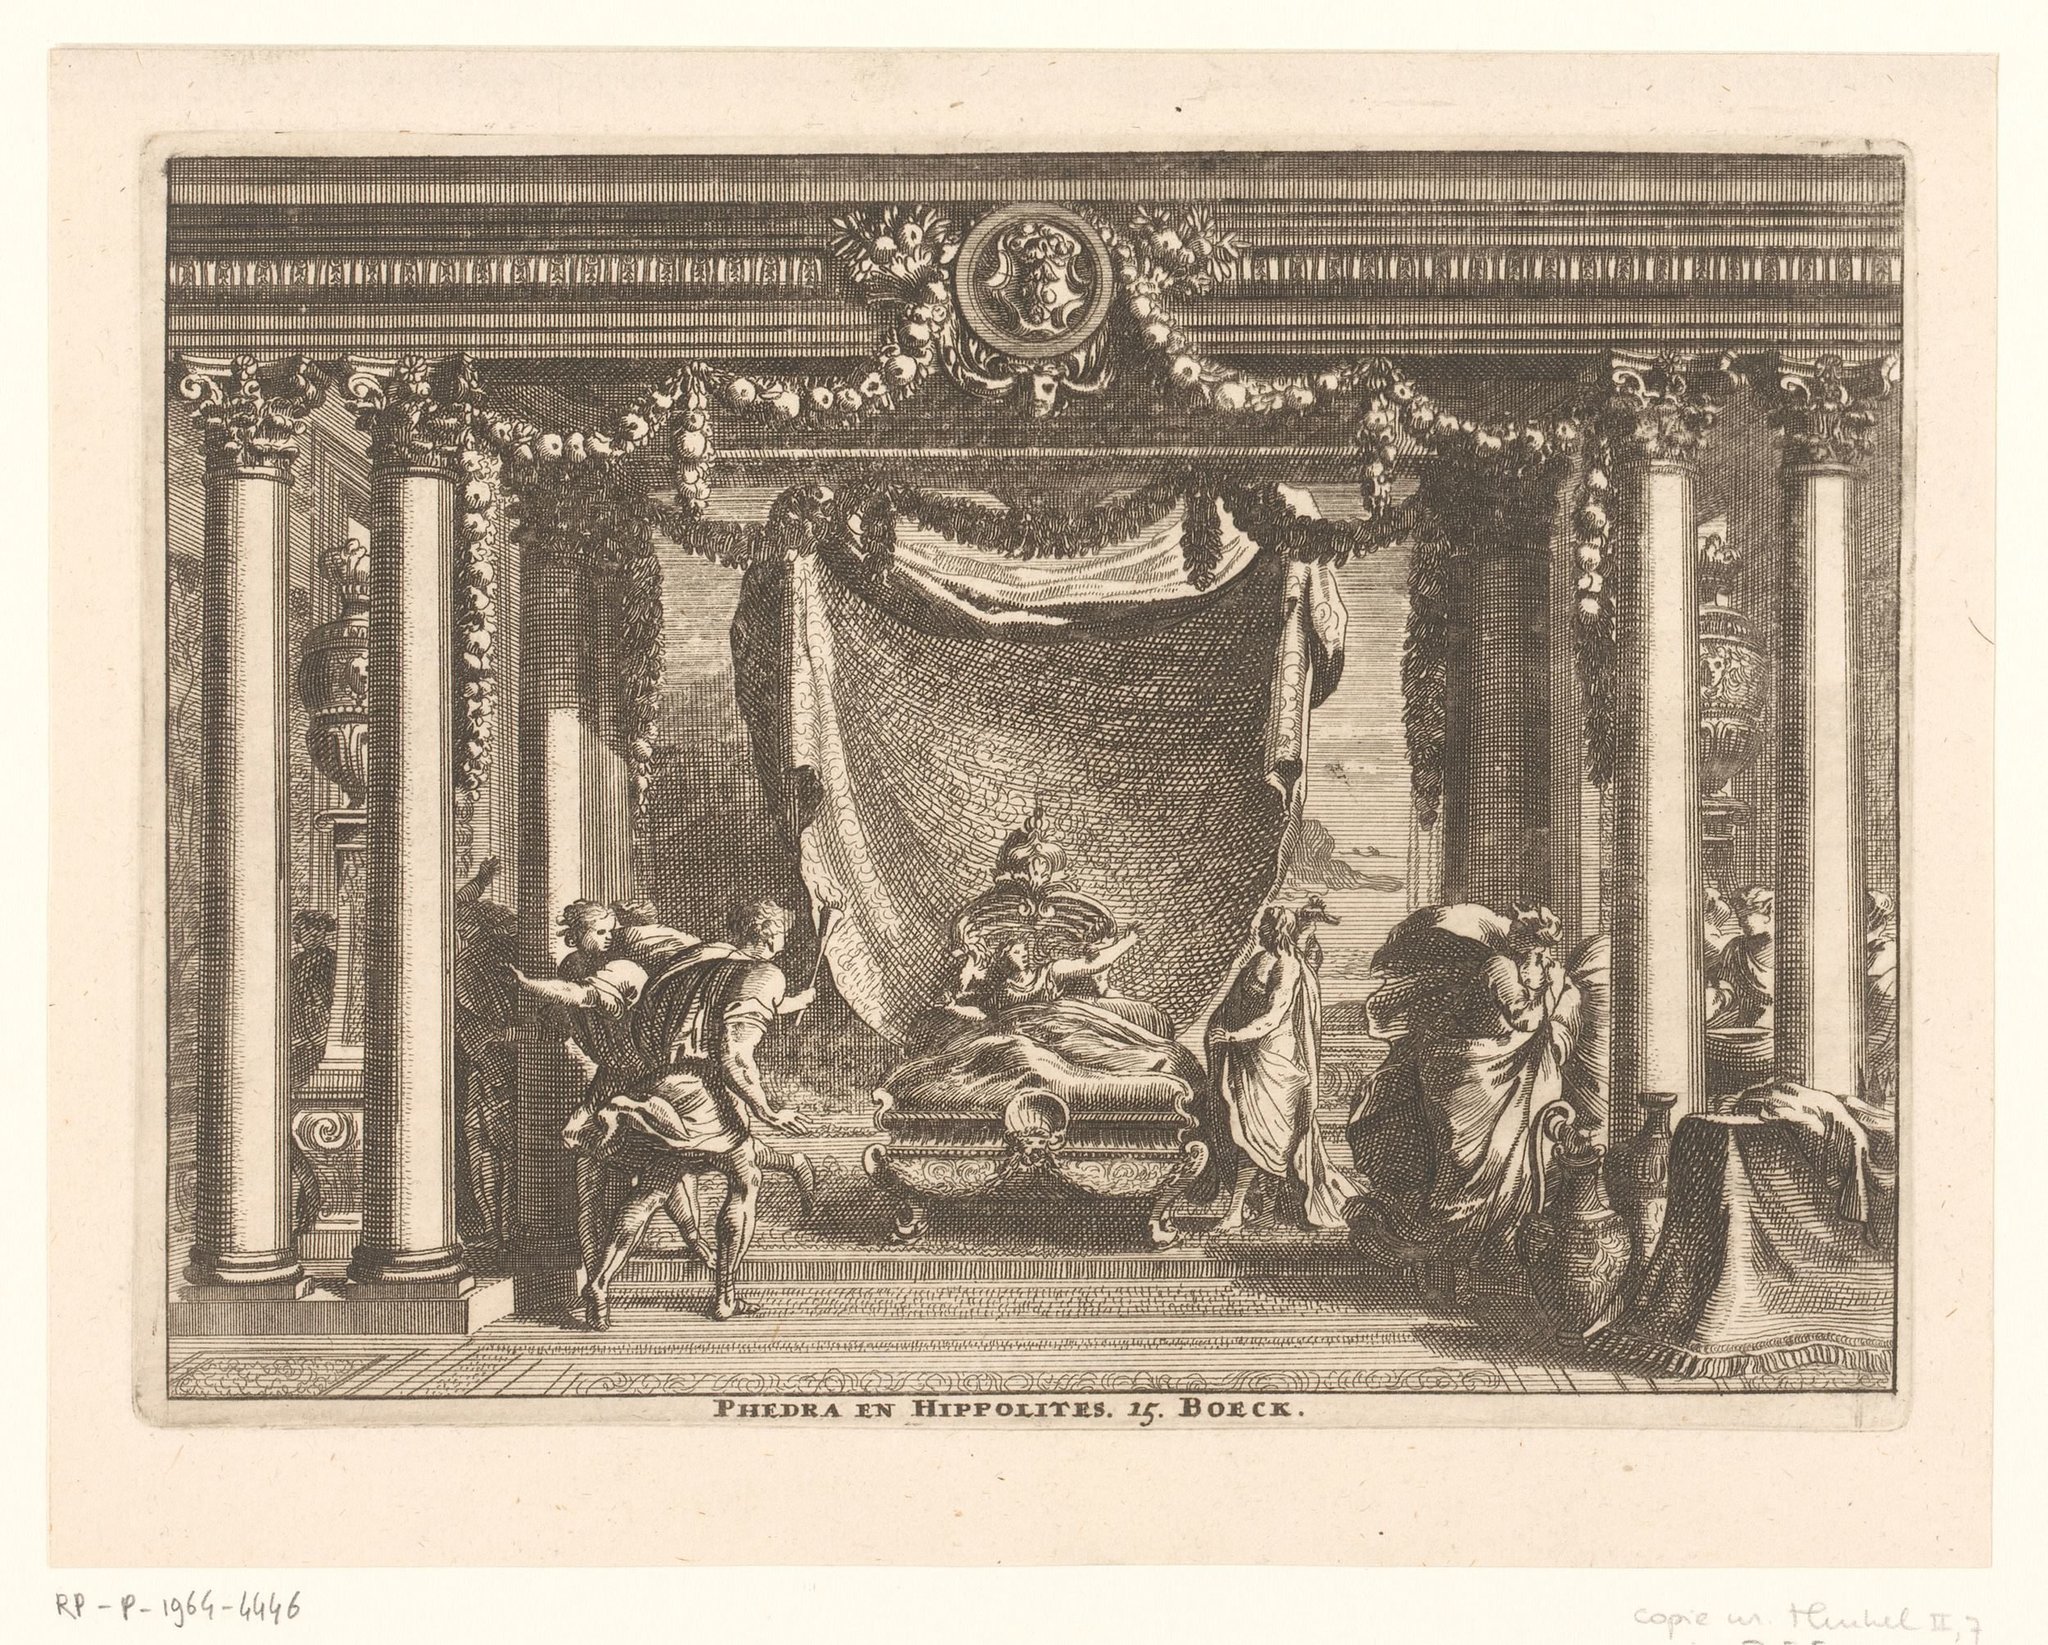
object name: print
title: Phedra en Hippolites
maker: Anonymous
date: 1628-1682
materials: paper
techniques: etching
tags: (story of) alcyone and ceyx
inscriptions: collector's mark: Lugt 2228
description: Lijkt deel uit te maken van een serie prenten met mythologische onderwerpen, naar prenten door Jean Lepautre en voorzien van Nederlandse titels. Mogelijk werd de serie uitgegeven door Cornelis (I) of Cornelis (II) Danckerts, zoals vermeld op RP-P-1964-4431 en RP-P-1964-4443.